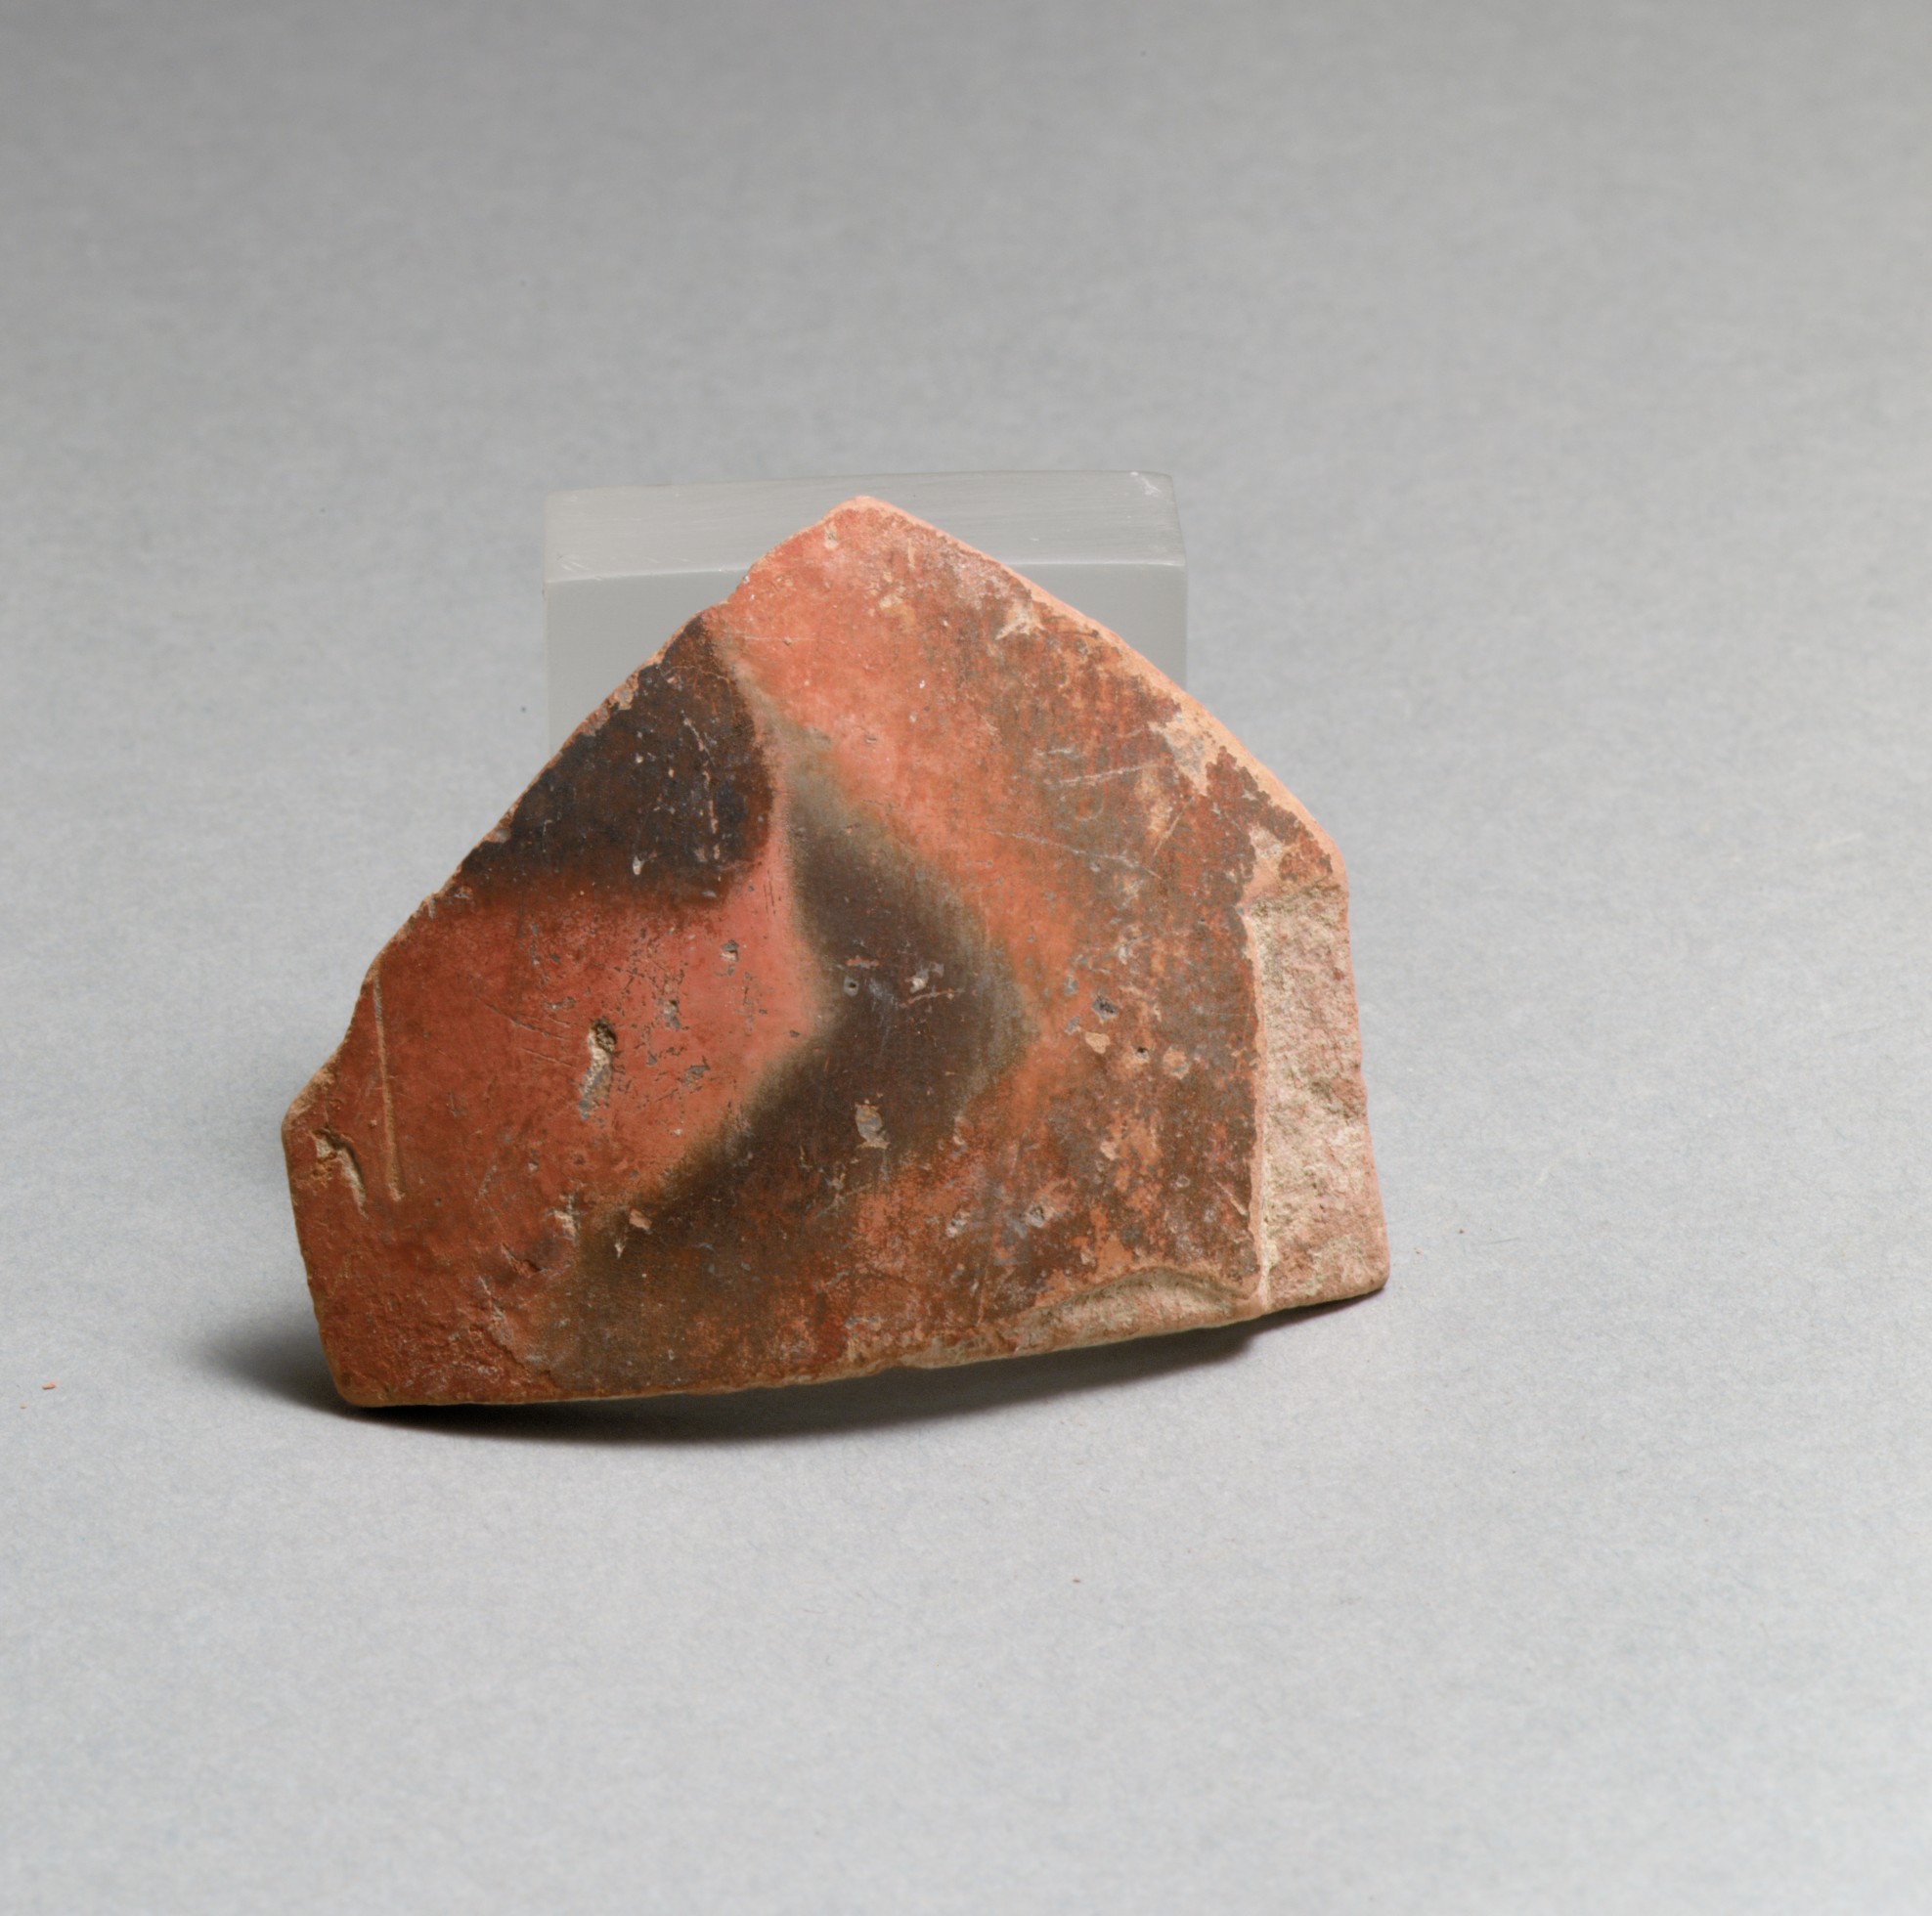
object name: vase fragment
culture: minoan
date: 2600-2000 BCE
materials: terracotta